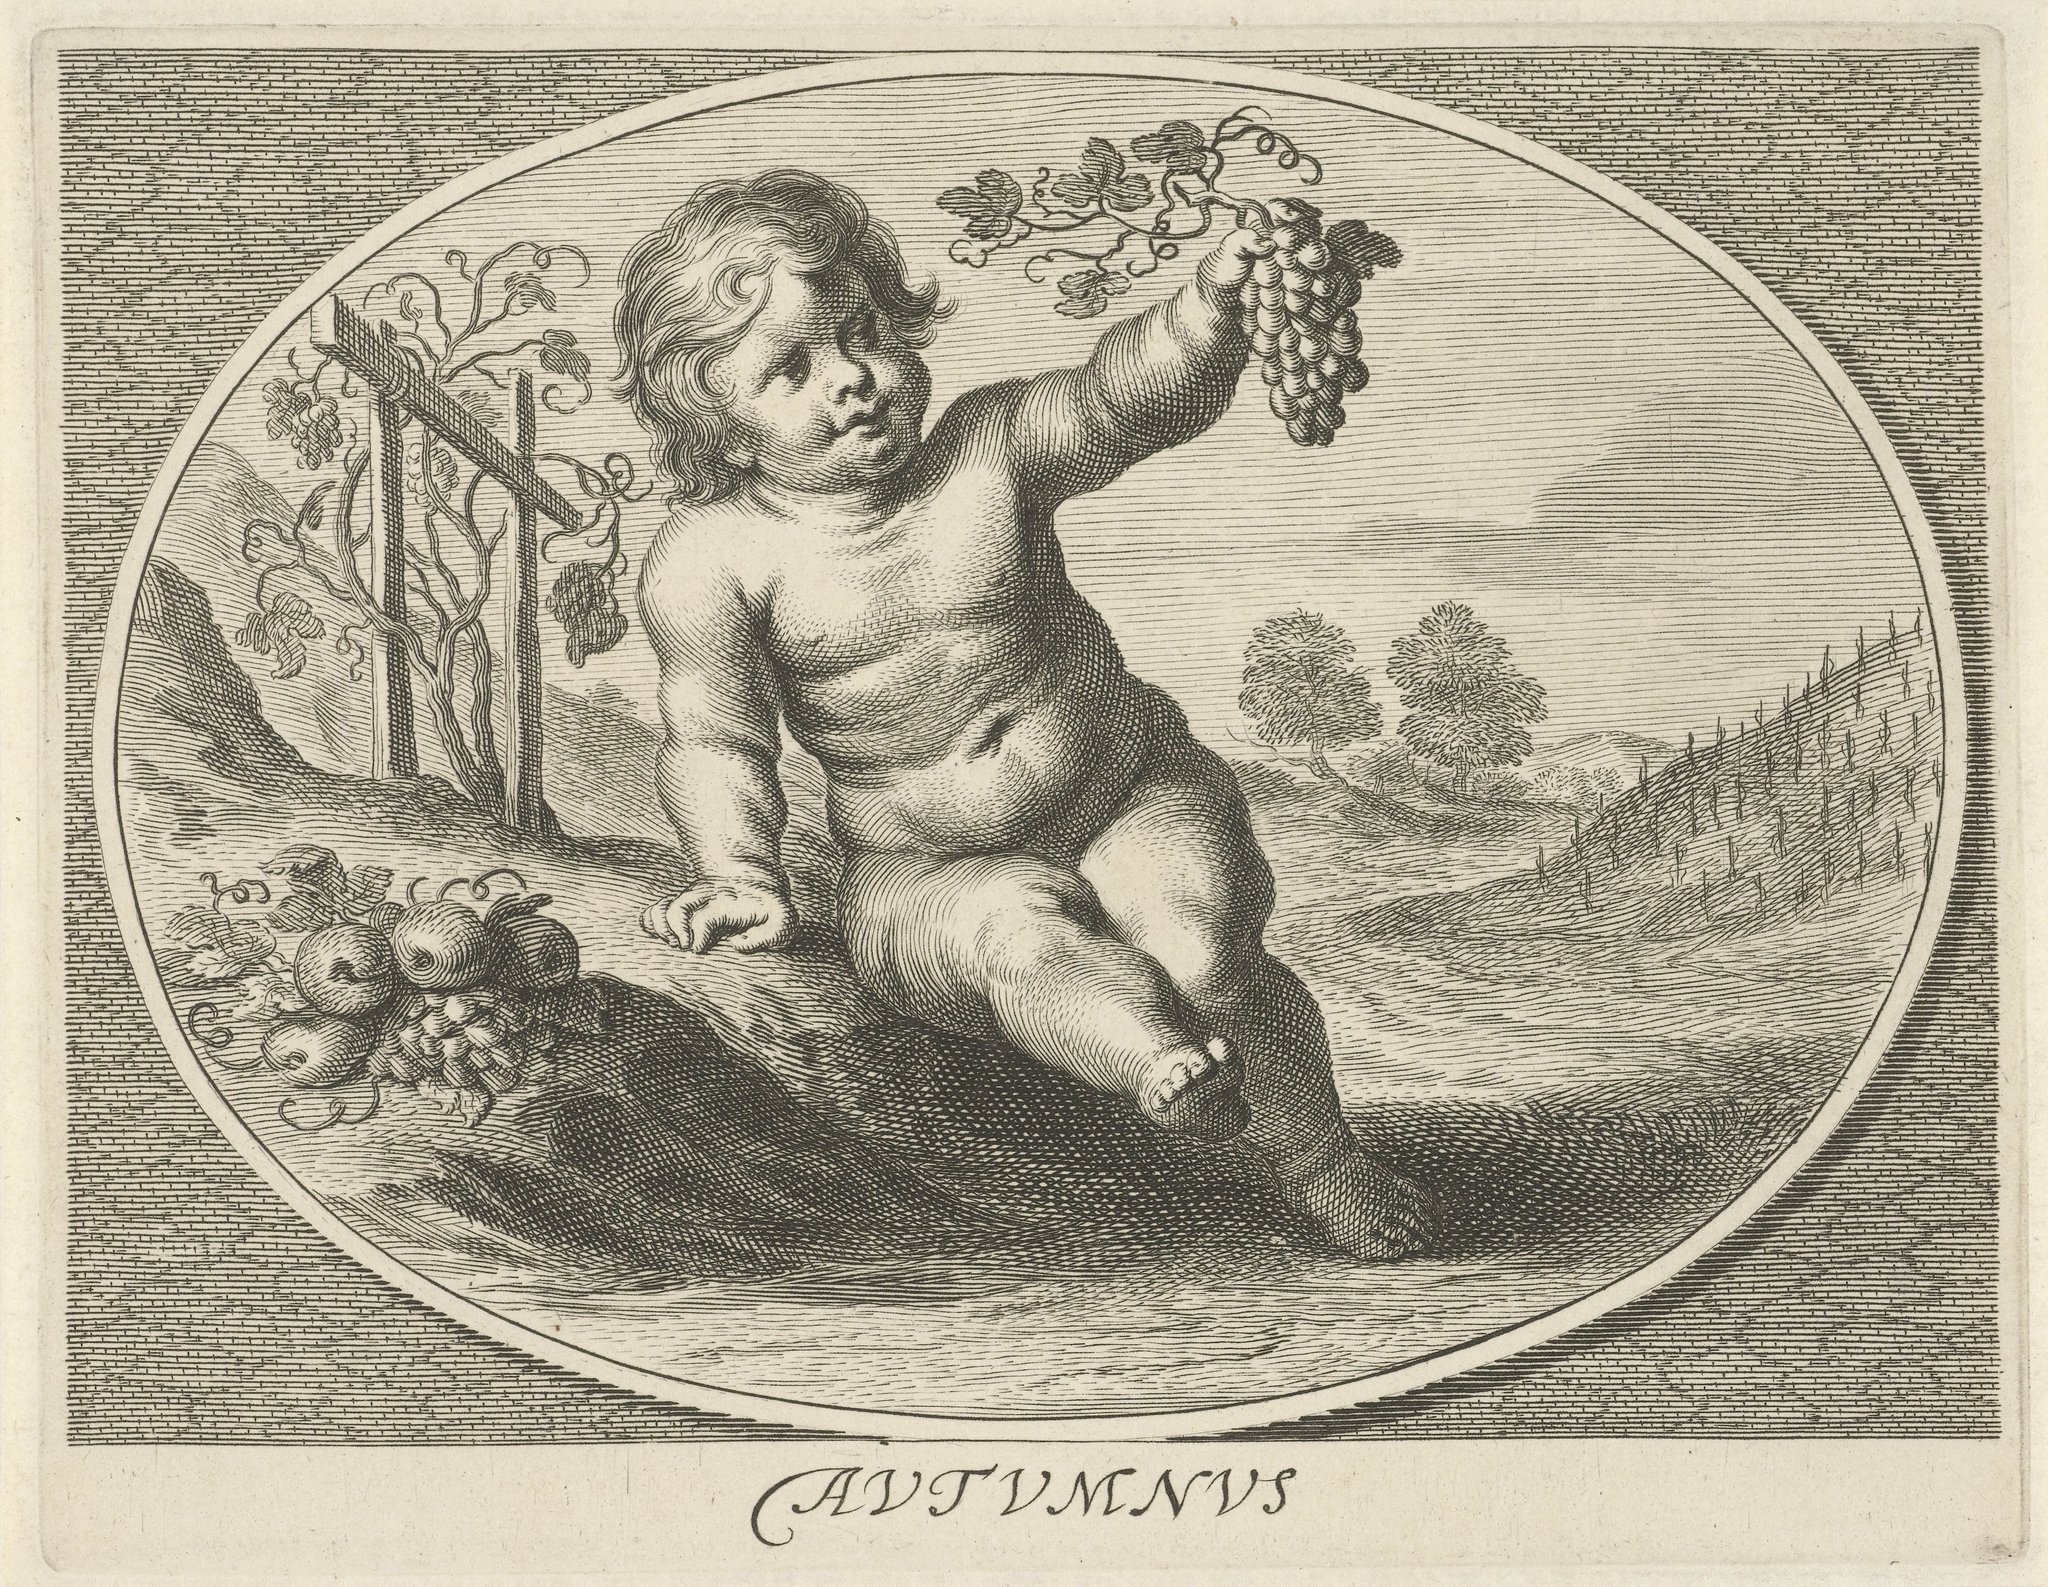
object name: print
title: Vier jaargetijden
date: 1648-1664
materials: paper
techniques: engraving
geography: amsterdam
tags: autumn, fall, 'autumnus'; 'autunno' (ripa)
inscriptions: collector's mark: Lugt 240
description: Prent uit serie van vier prenten met de vier jaargetijden.